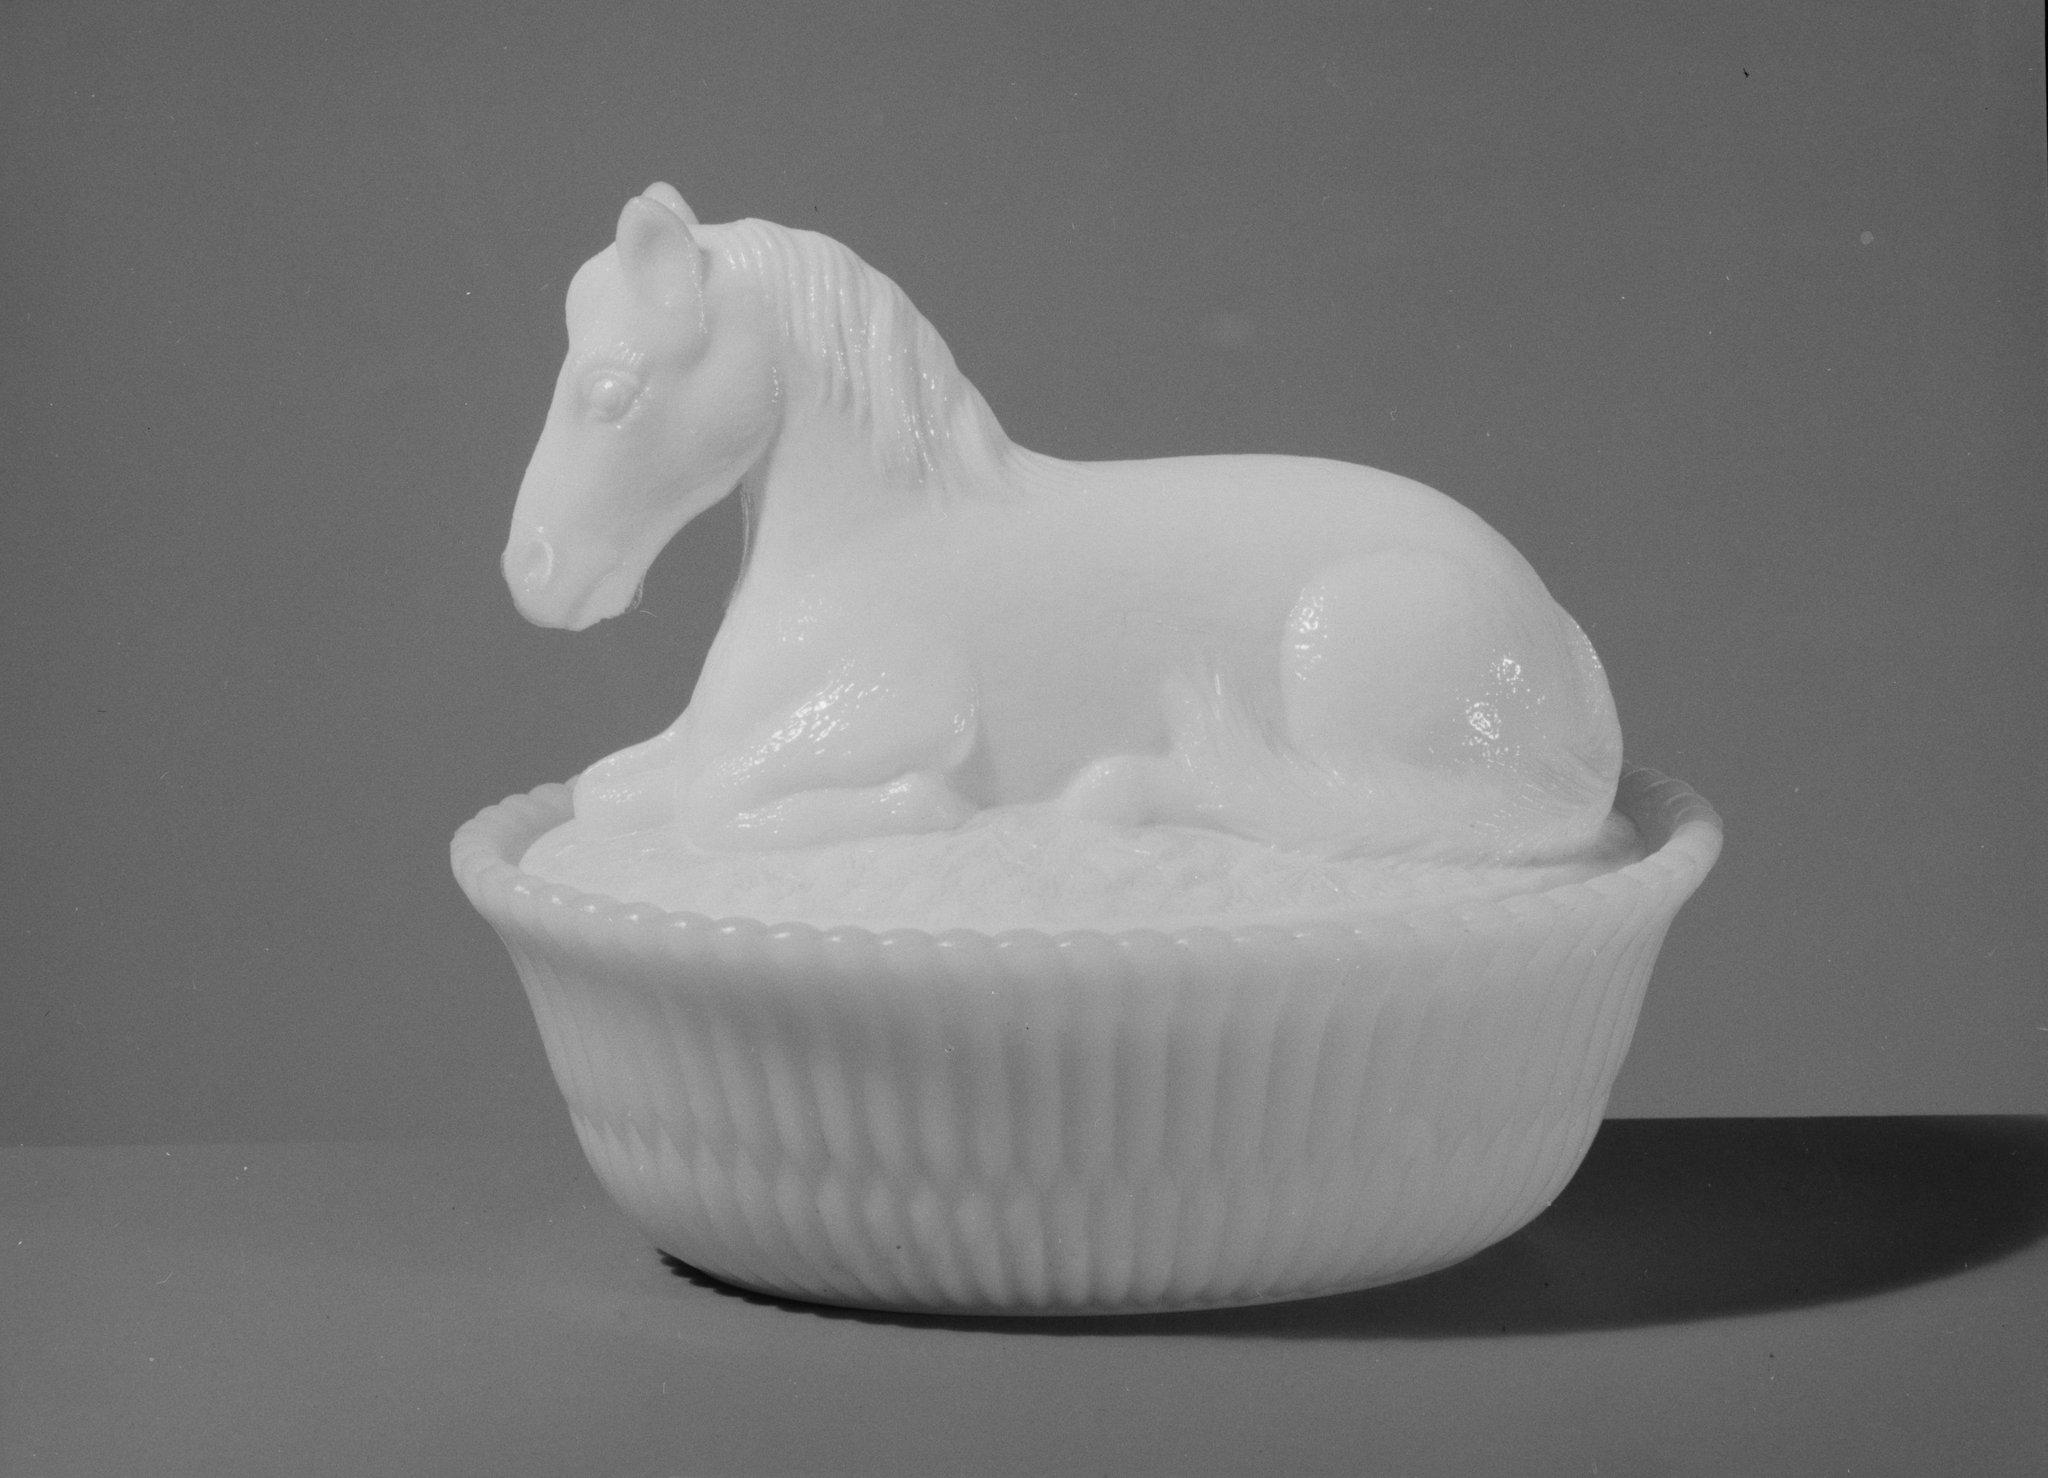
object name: dish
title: Figure Dish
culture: american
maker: mckee and brothers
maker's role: maker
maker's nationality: american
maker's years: 1856-1889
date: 1880-1890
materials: glass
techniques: pressed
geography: united states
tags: horses